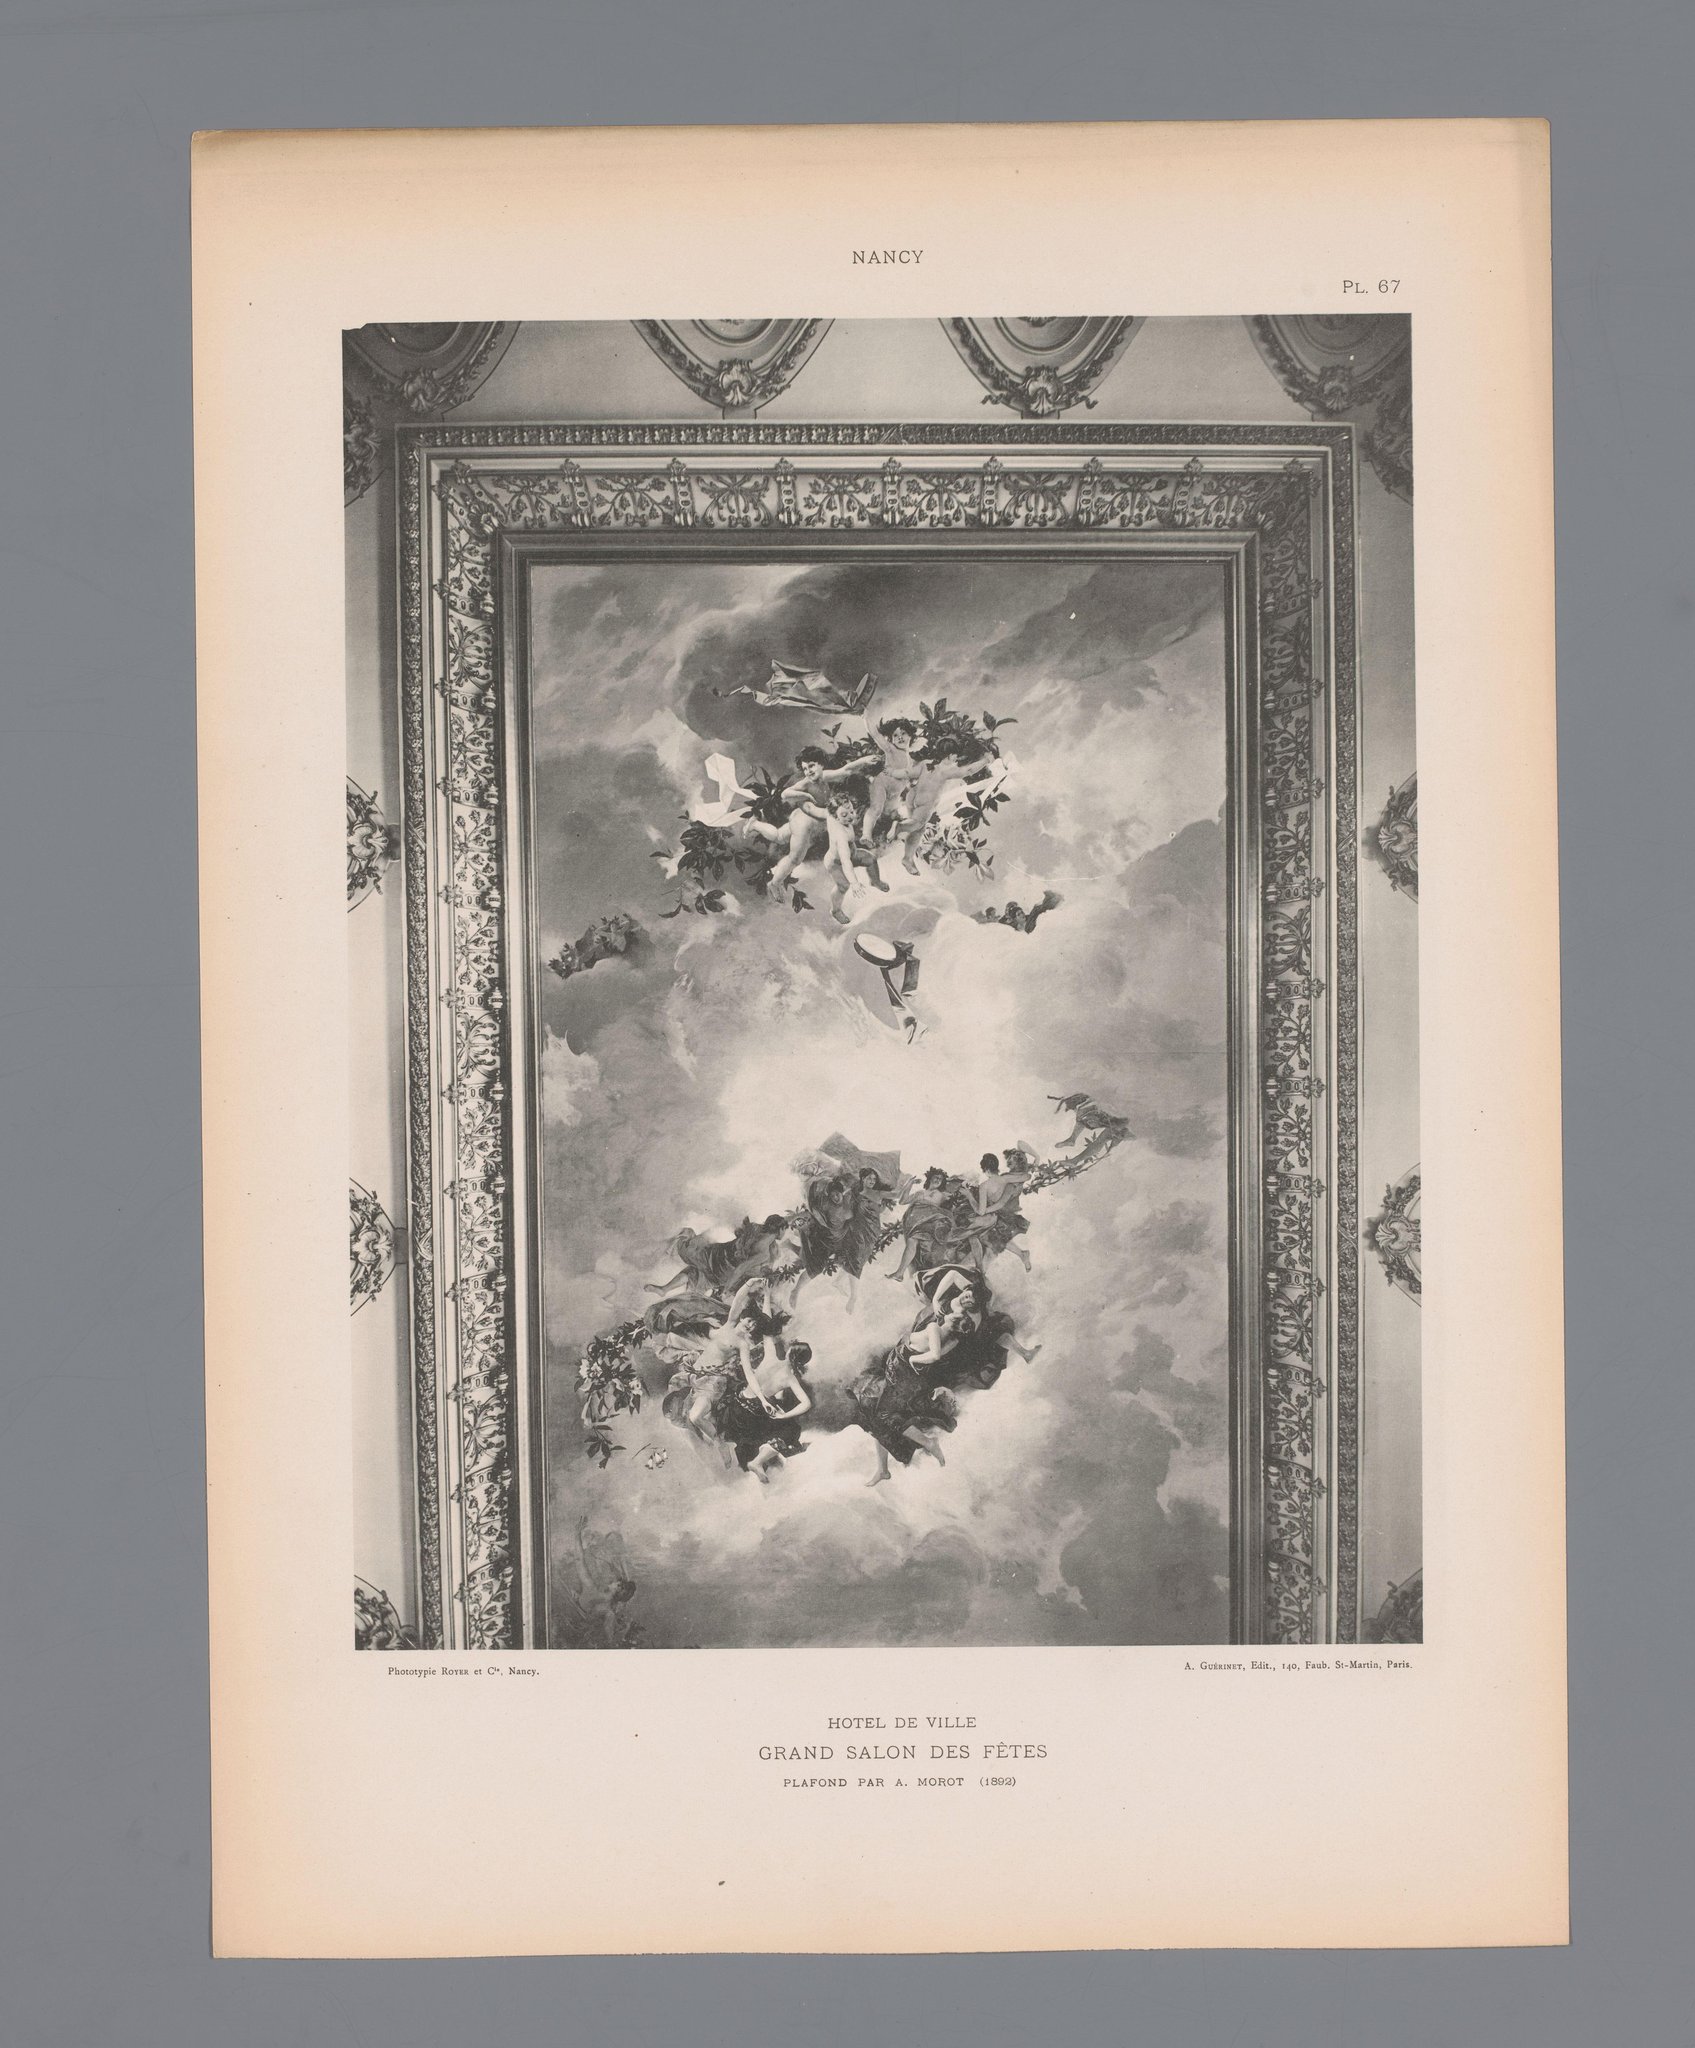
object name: photomechanical print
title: Plafond van de feestzaal in het stadhuis te Nancy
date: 1891-1896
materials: paper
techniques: photograph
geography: nancy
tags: townhall, (decorated) ceiling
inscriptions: inscription: ‘Hotel de ville/ Grand salon des fêtes/ plafond par A. Morot (1892)’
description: Deze prent maakt deel uit van een omslag met 103 prenten op 101 bladen en een titelblad.